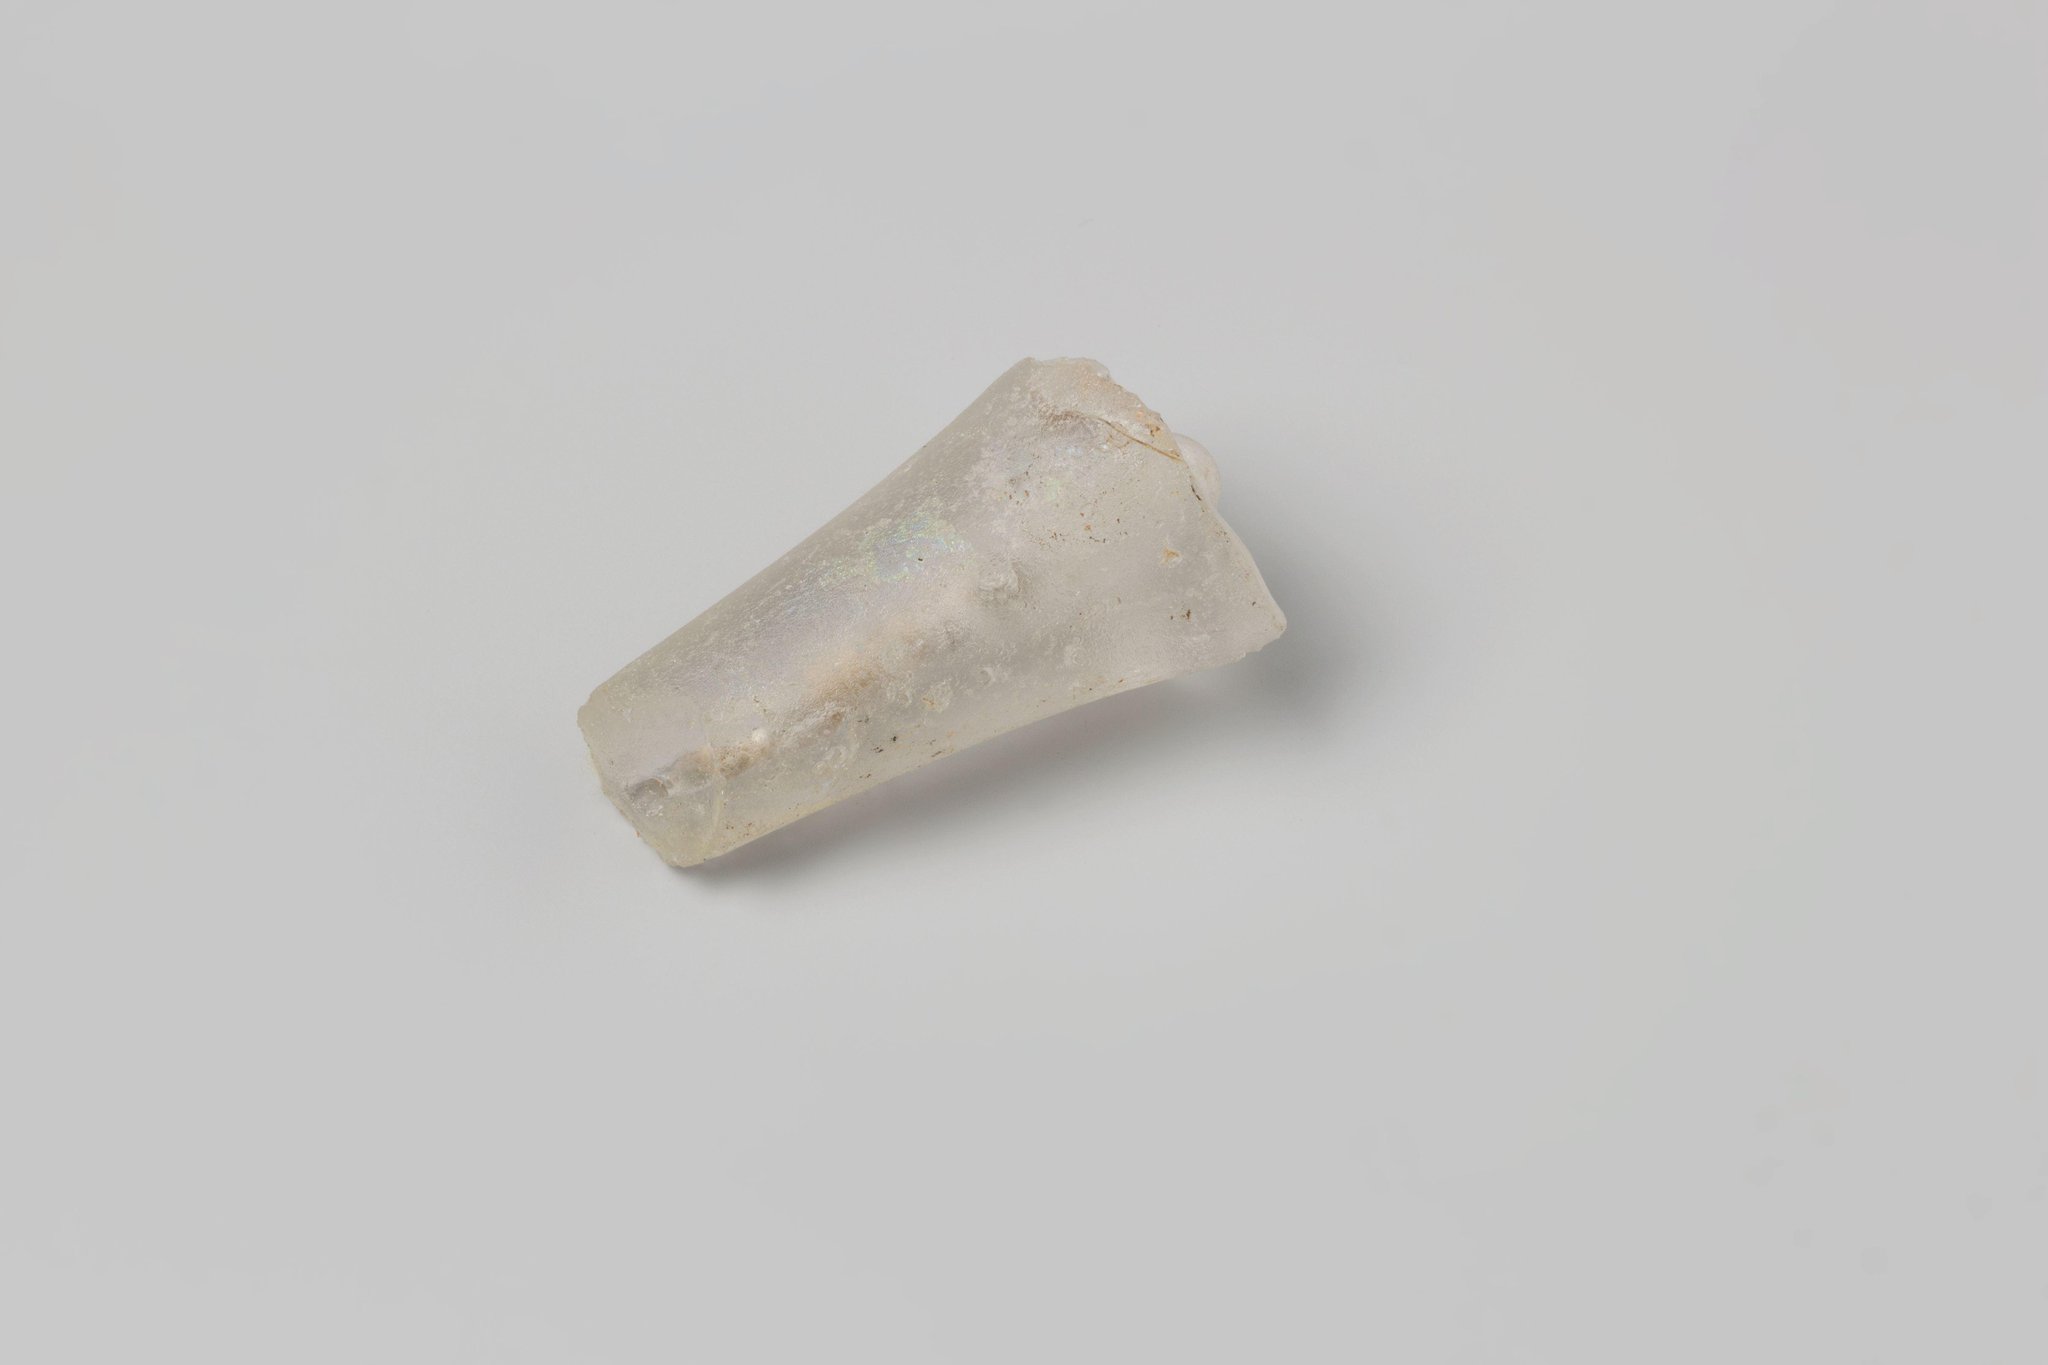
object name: helve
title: Fragment rechte steel van glas uit het wrak van de Oost-Indiëvaarder Hollandia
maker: Anonymous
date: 1700-1743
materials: glass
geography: netherlands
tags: verenigde oostindische compagnie, hollandia (schip), annet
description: Glass, stem glass, stems, plain; fragm, id. NG 1980-27H798.